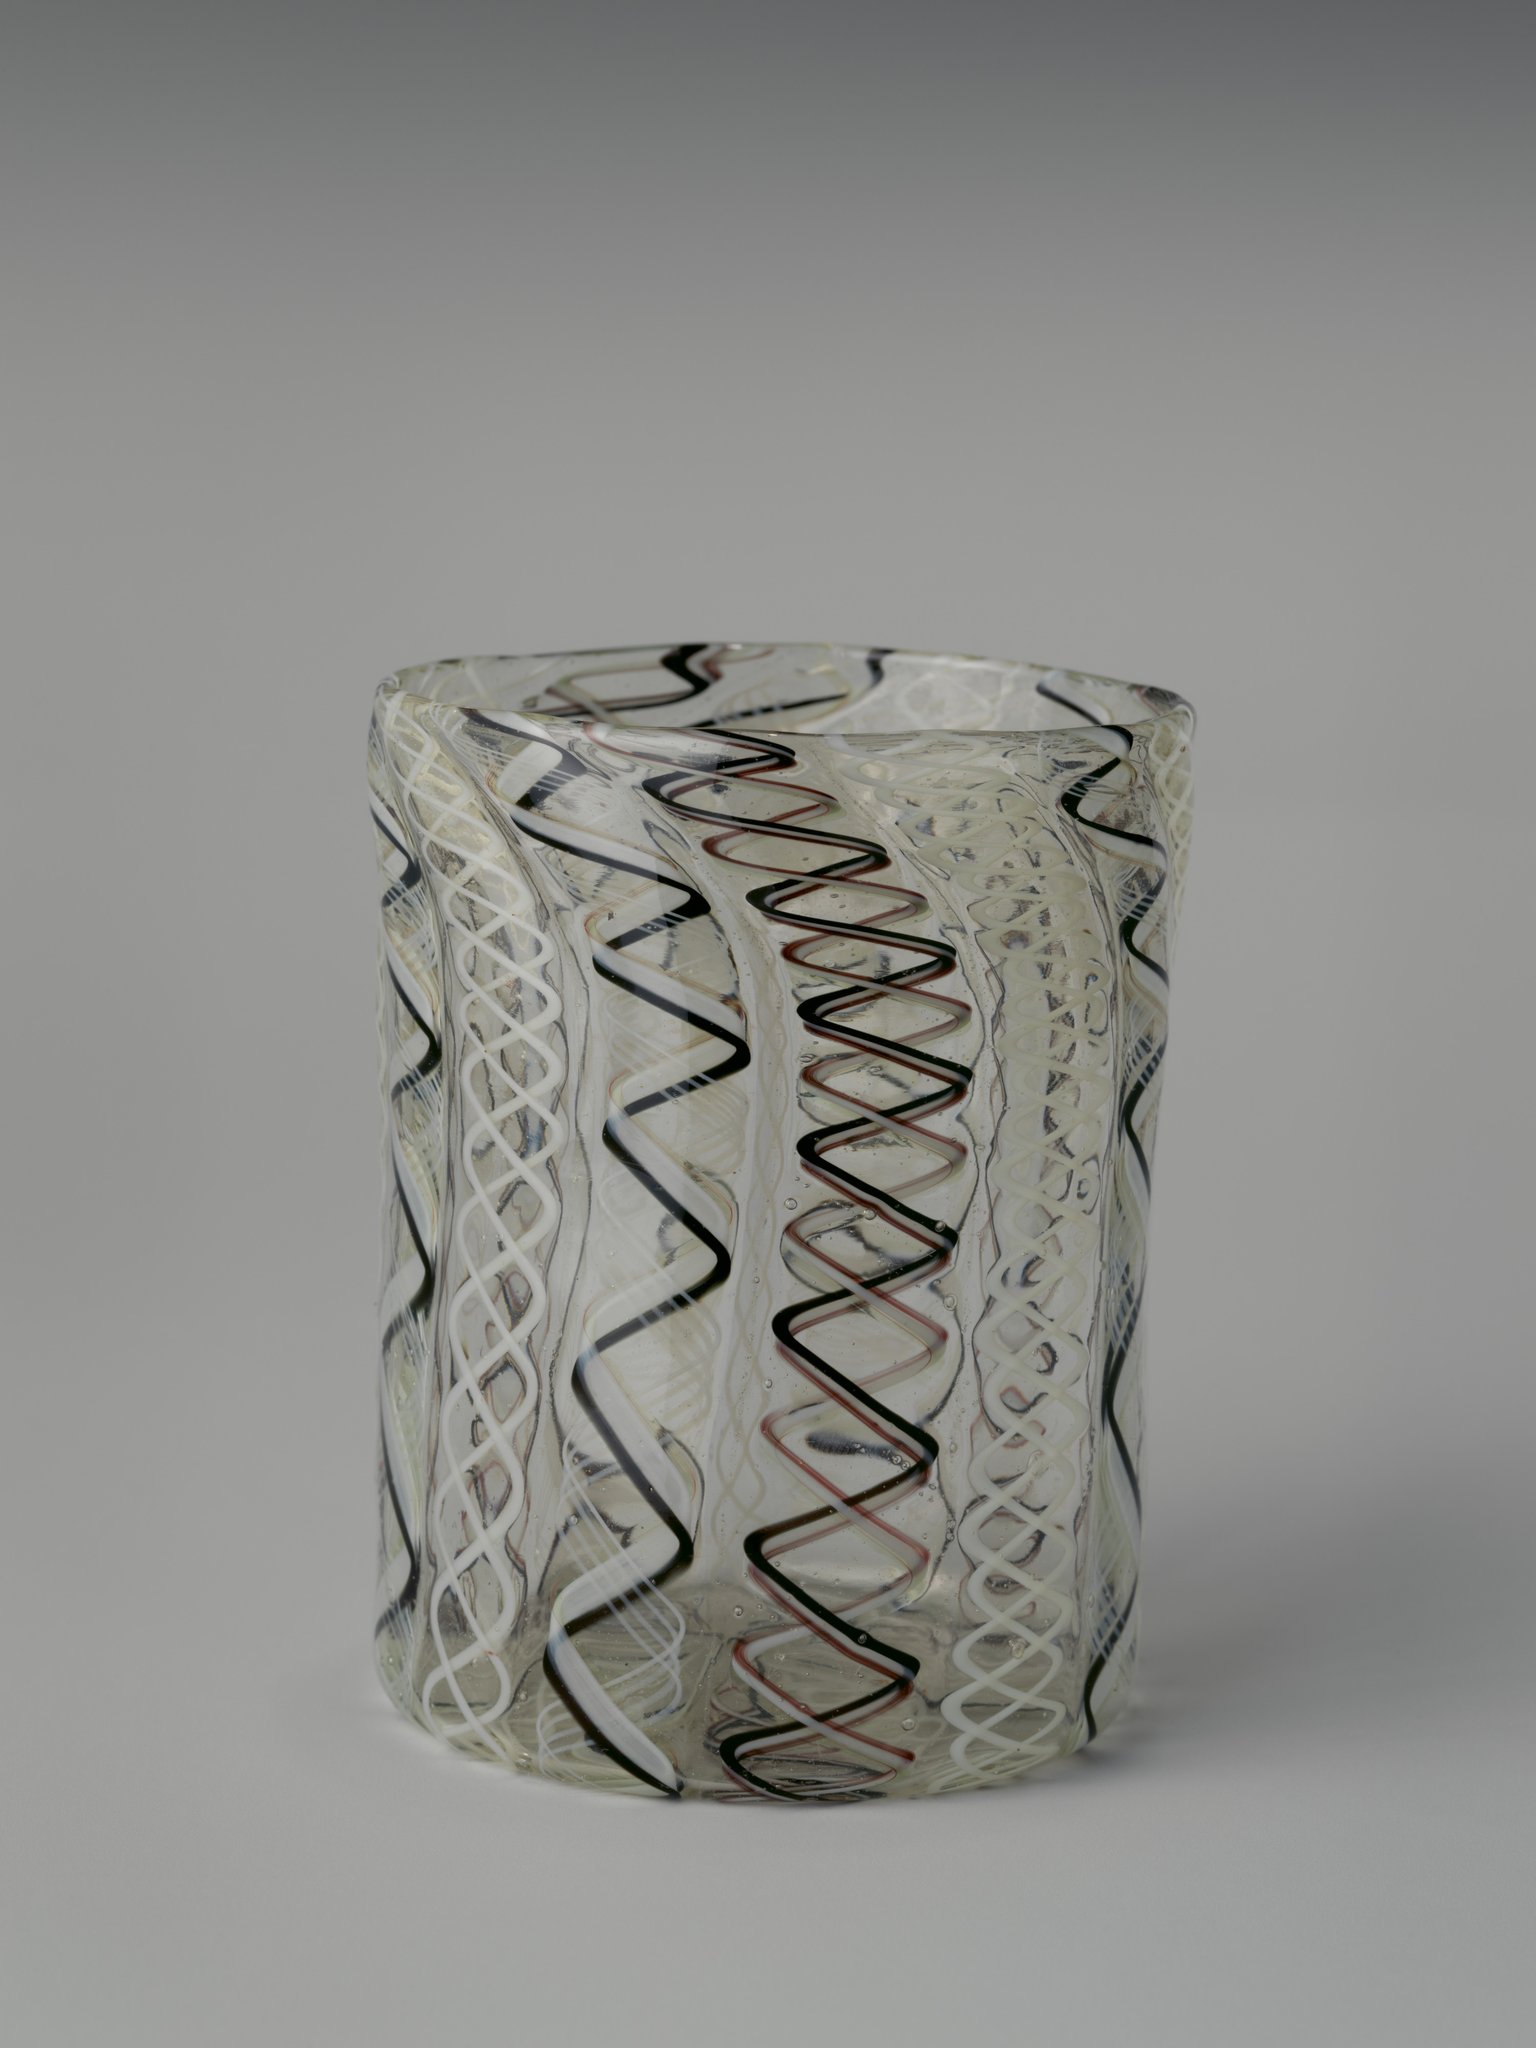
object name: beaker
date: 1834-1866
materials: glass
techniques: glassblowing